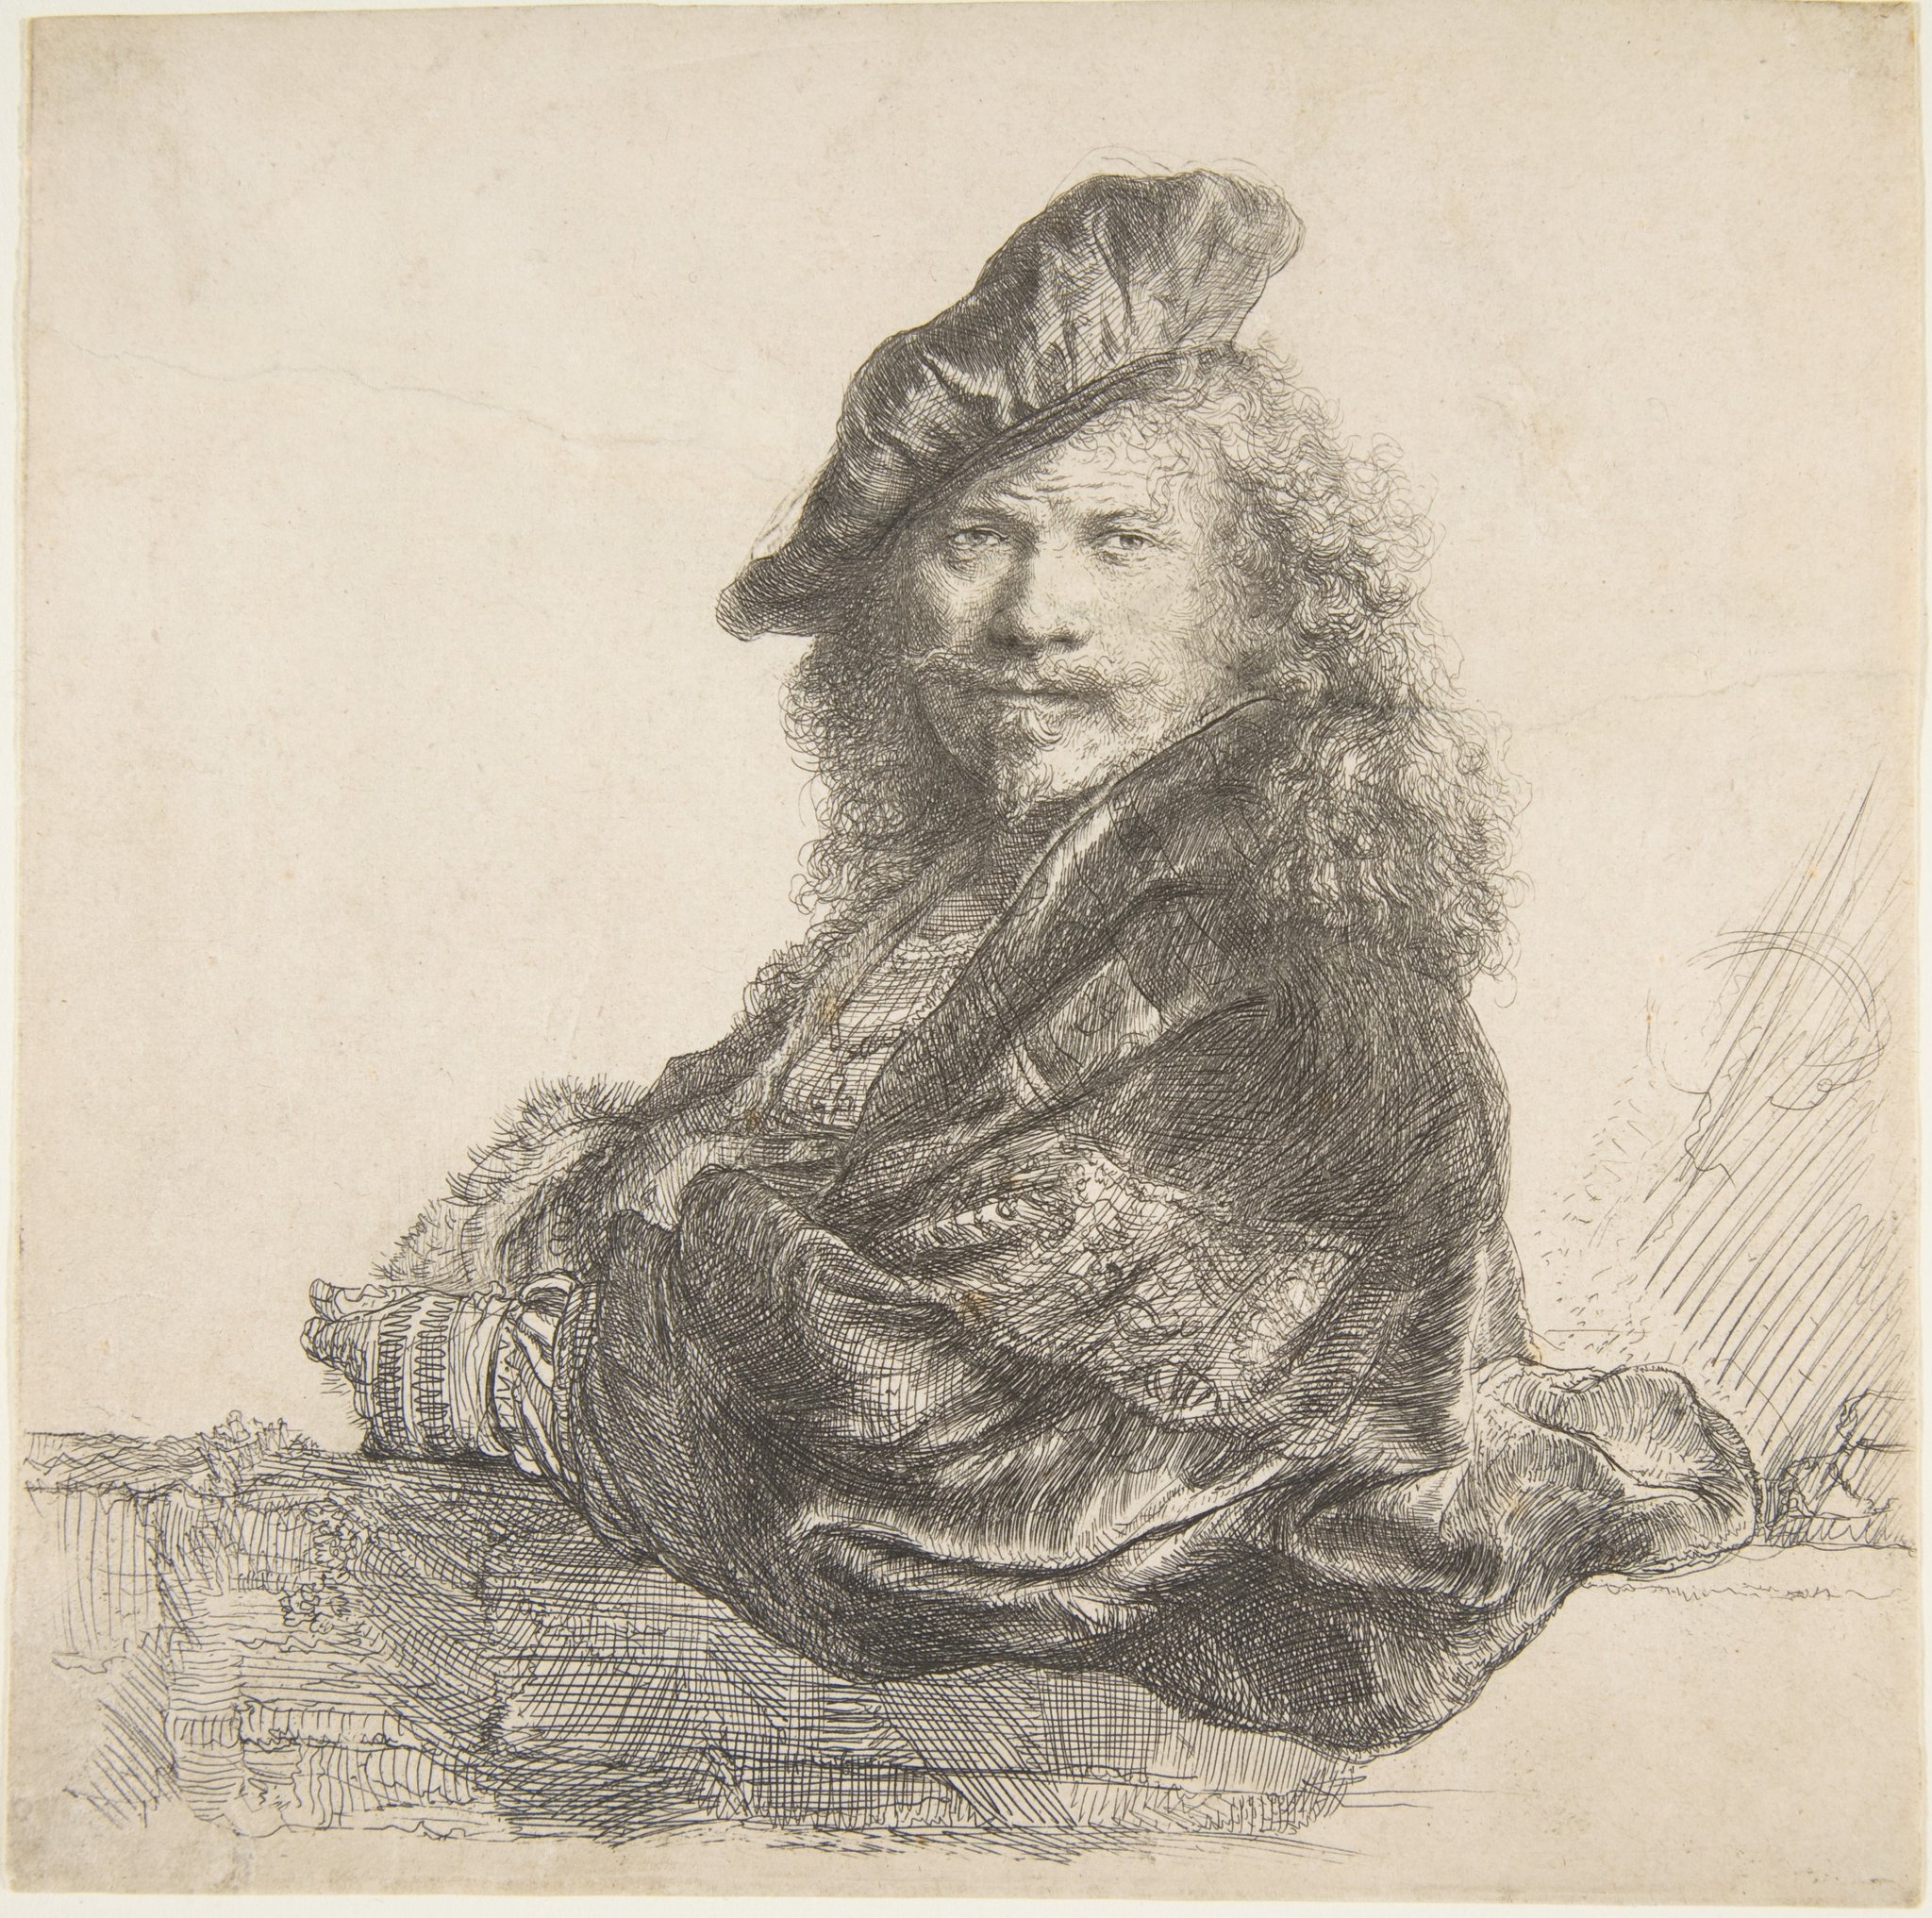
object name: print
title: Self-Portrait, Leaning on a Stone Wall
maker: rembrandt van rijn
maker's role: artist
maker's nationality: dutch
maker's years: 1606-1669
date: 1639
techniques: etching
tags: men,self-portraits